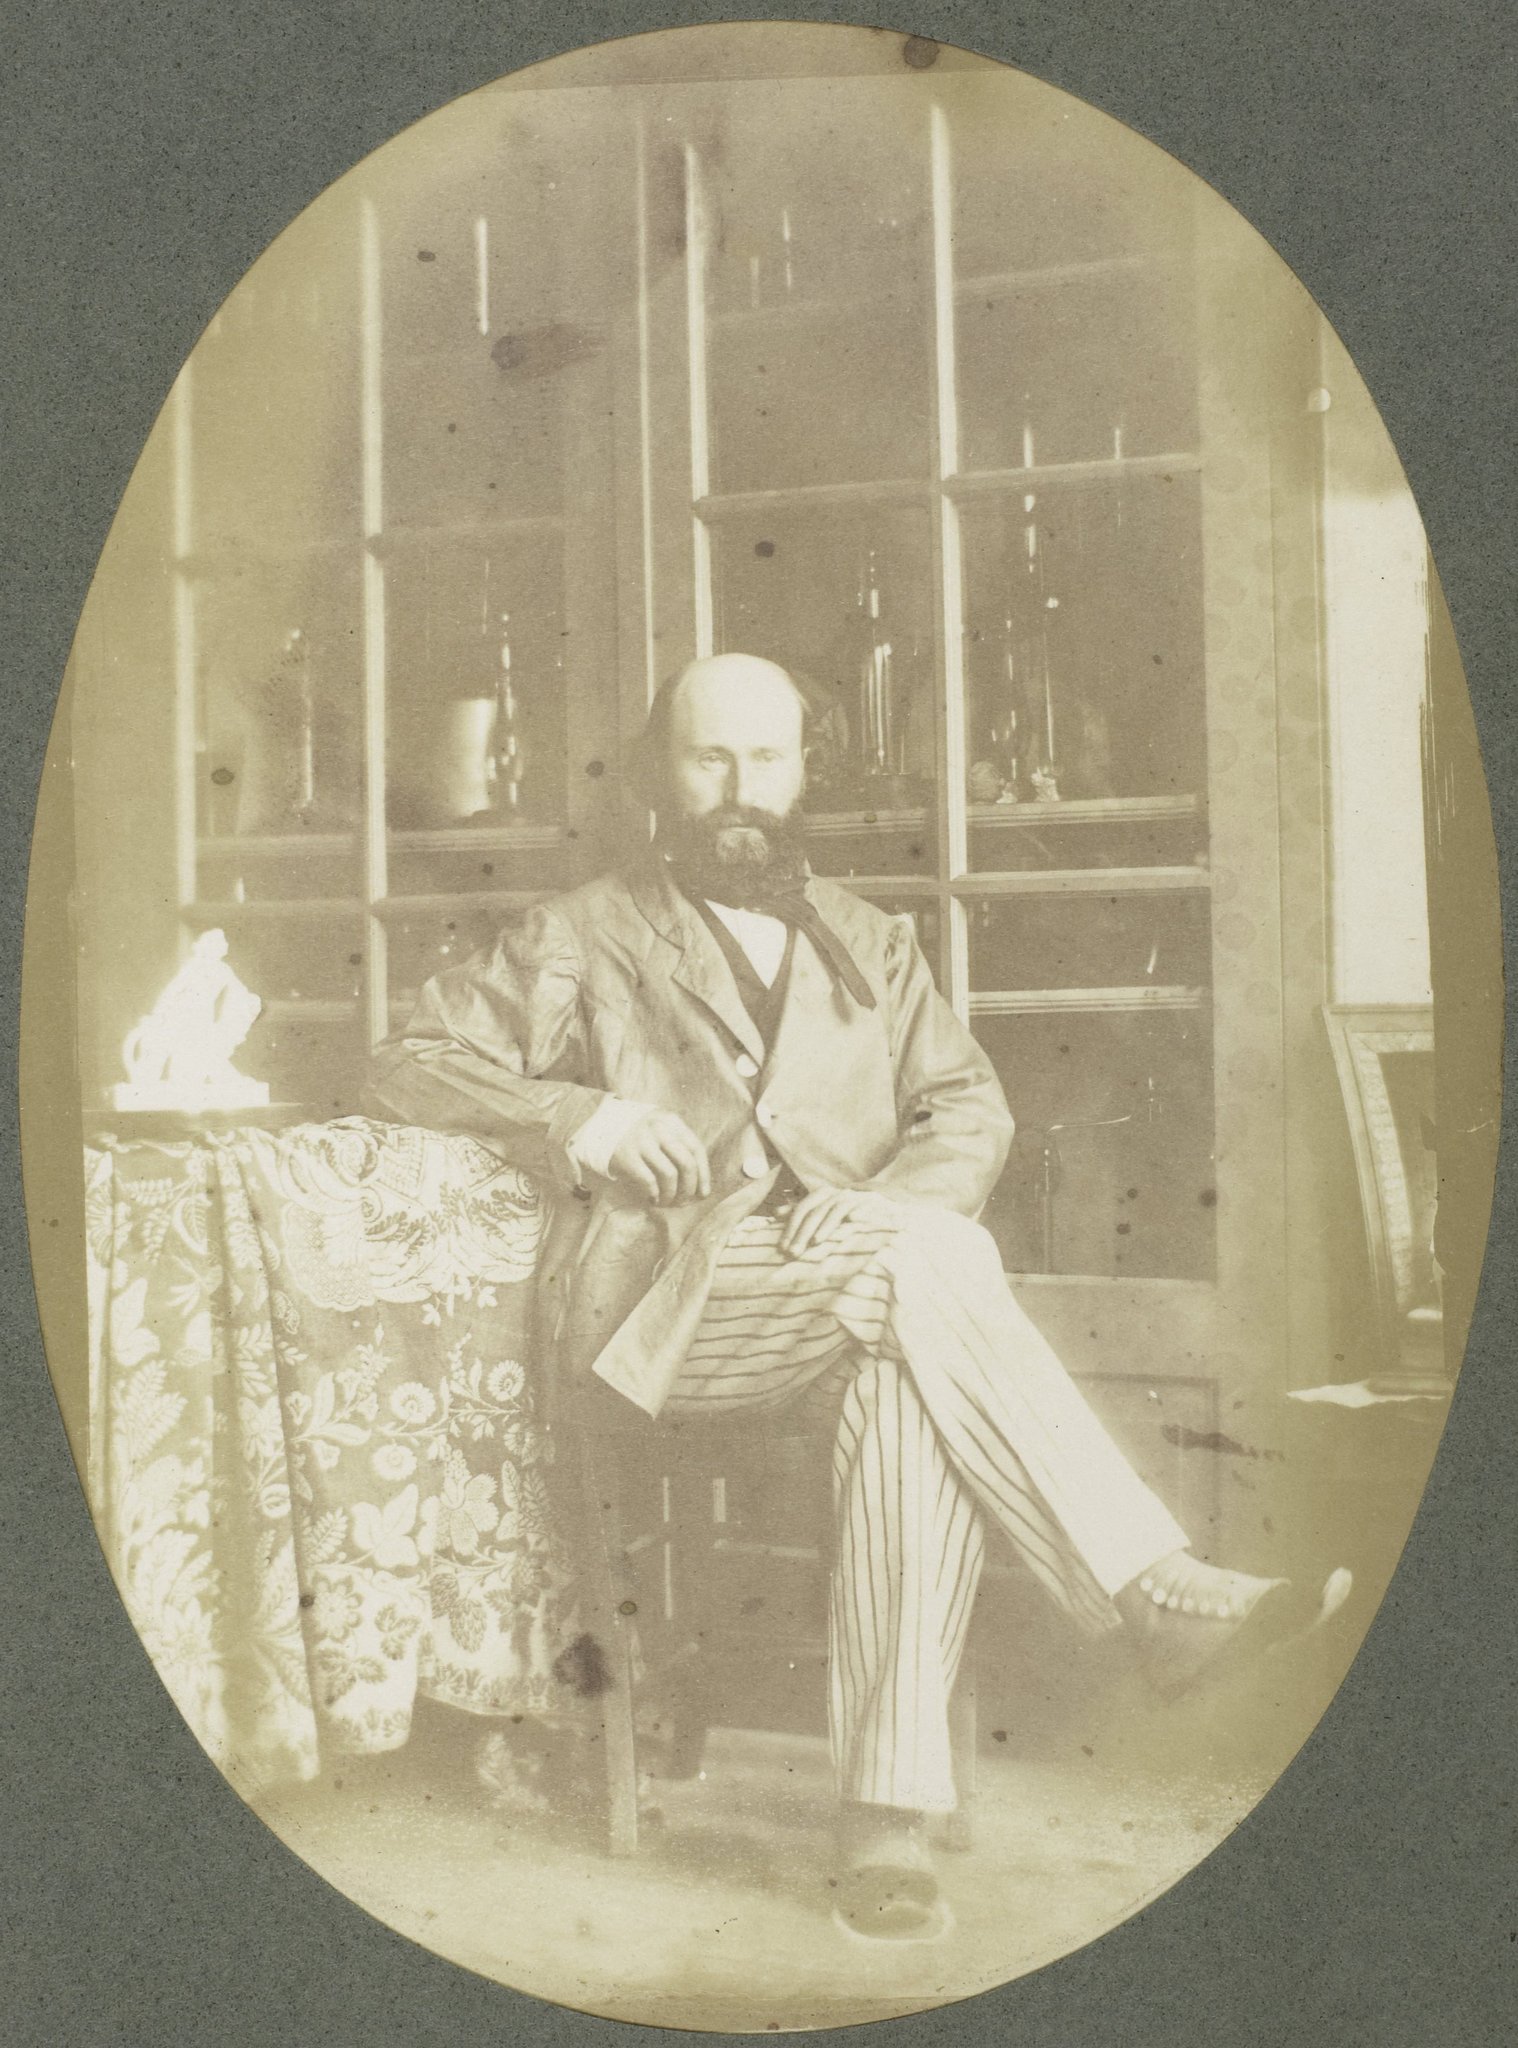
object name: photograph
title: Portret van Marie Eugène Bour voor een instrumentenkast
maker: eduard isaac asser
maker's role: amateurfotograaf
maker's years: 1809-1894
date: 1852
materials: cardboard, paper, photographic support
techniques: salted paper print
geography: amsterdam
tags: engineer, marie eugène bour, historical persons, netherlands